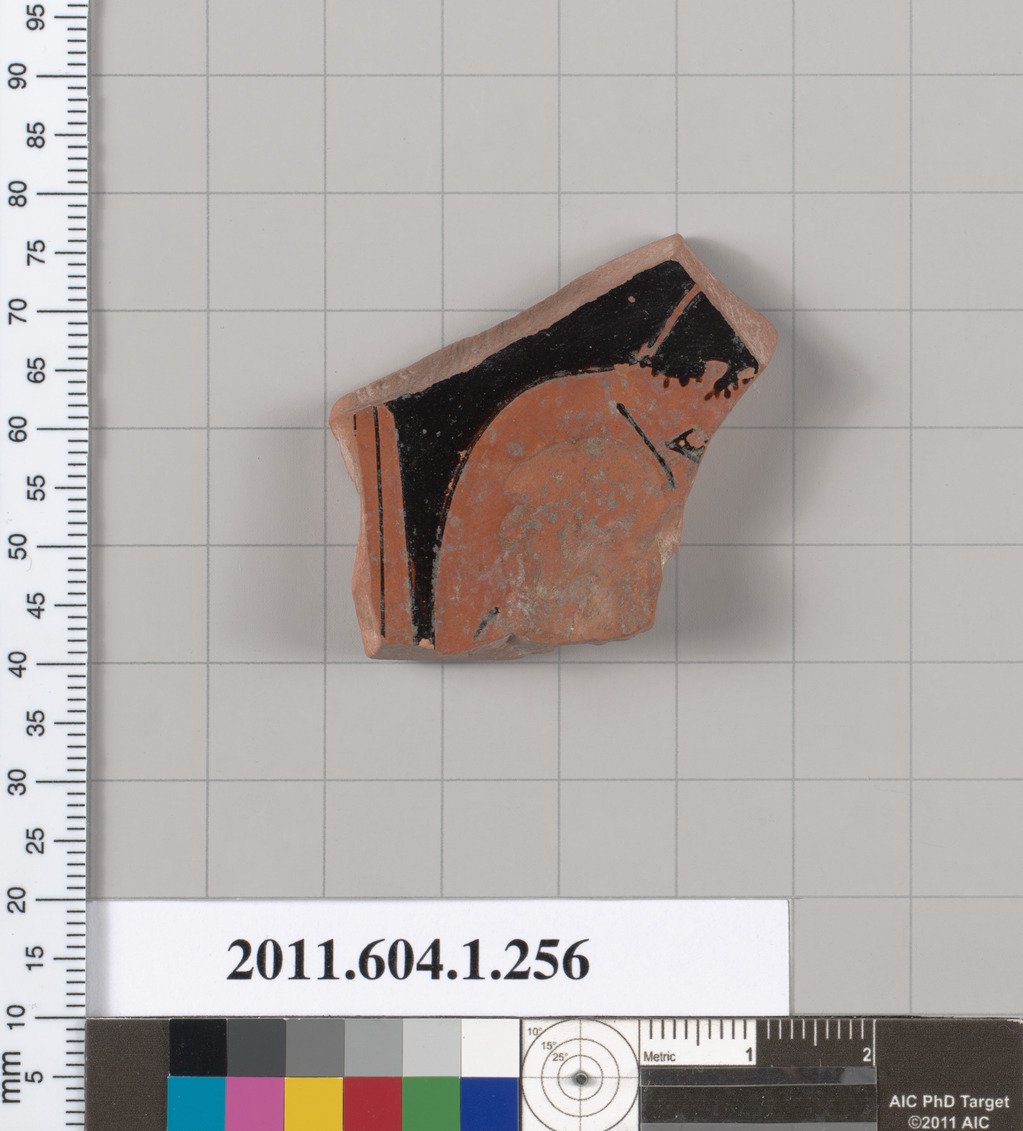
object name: kylix fragment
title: Terracotta fragment of a kylix (drinking cup)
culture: greek, attic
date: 475-451 BCE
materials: terracotta